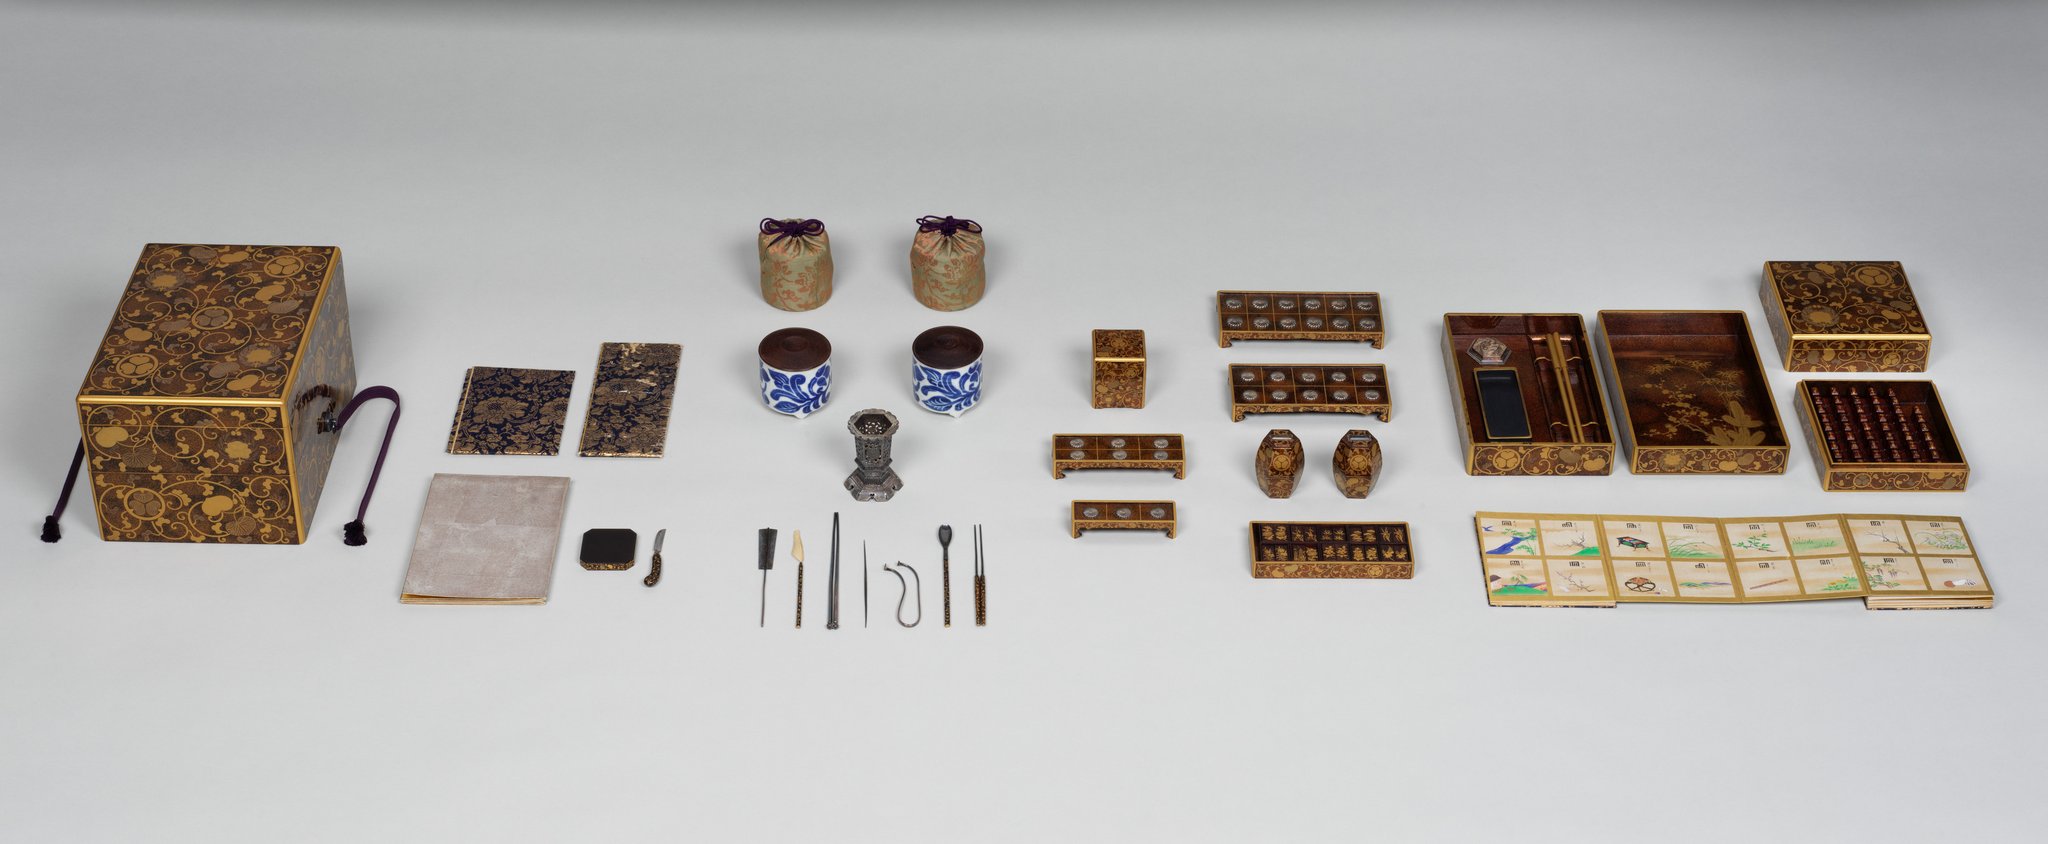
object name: incense game set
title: Ten-round incense game set with arabesque foliage and family crests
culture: japanese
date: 1856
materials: gold, silver, wood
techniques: hiramakie, lacquer